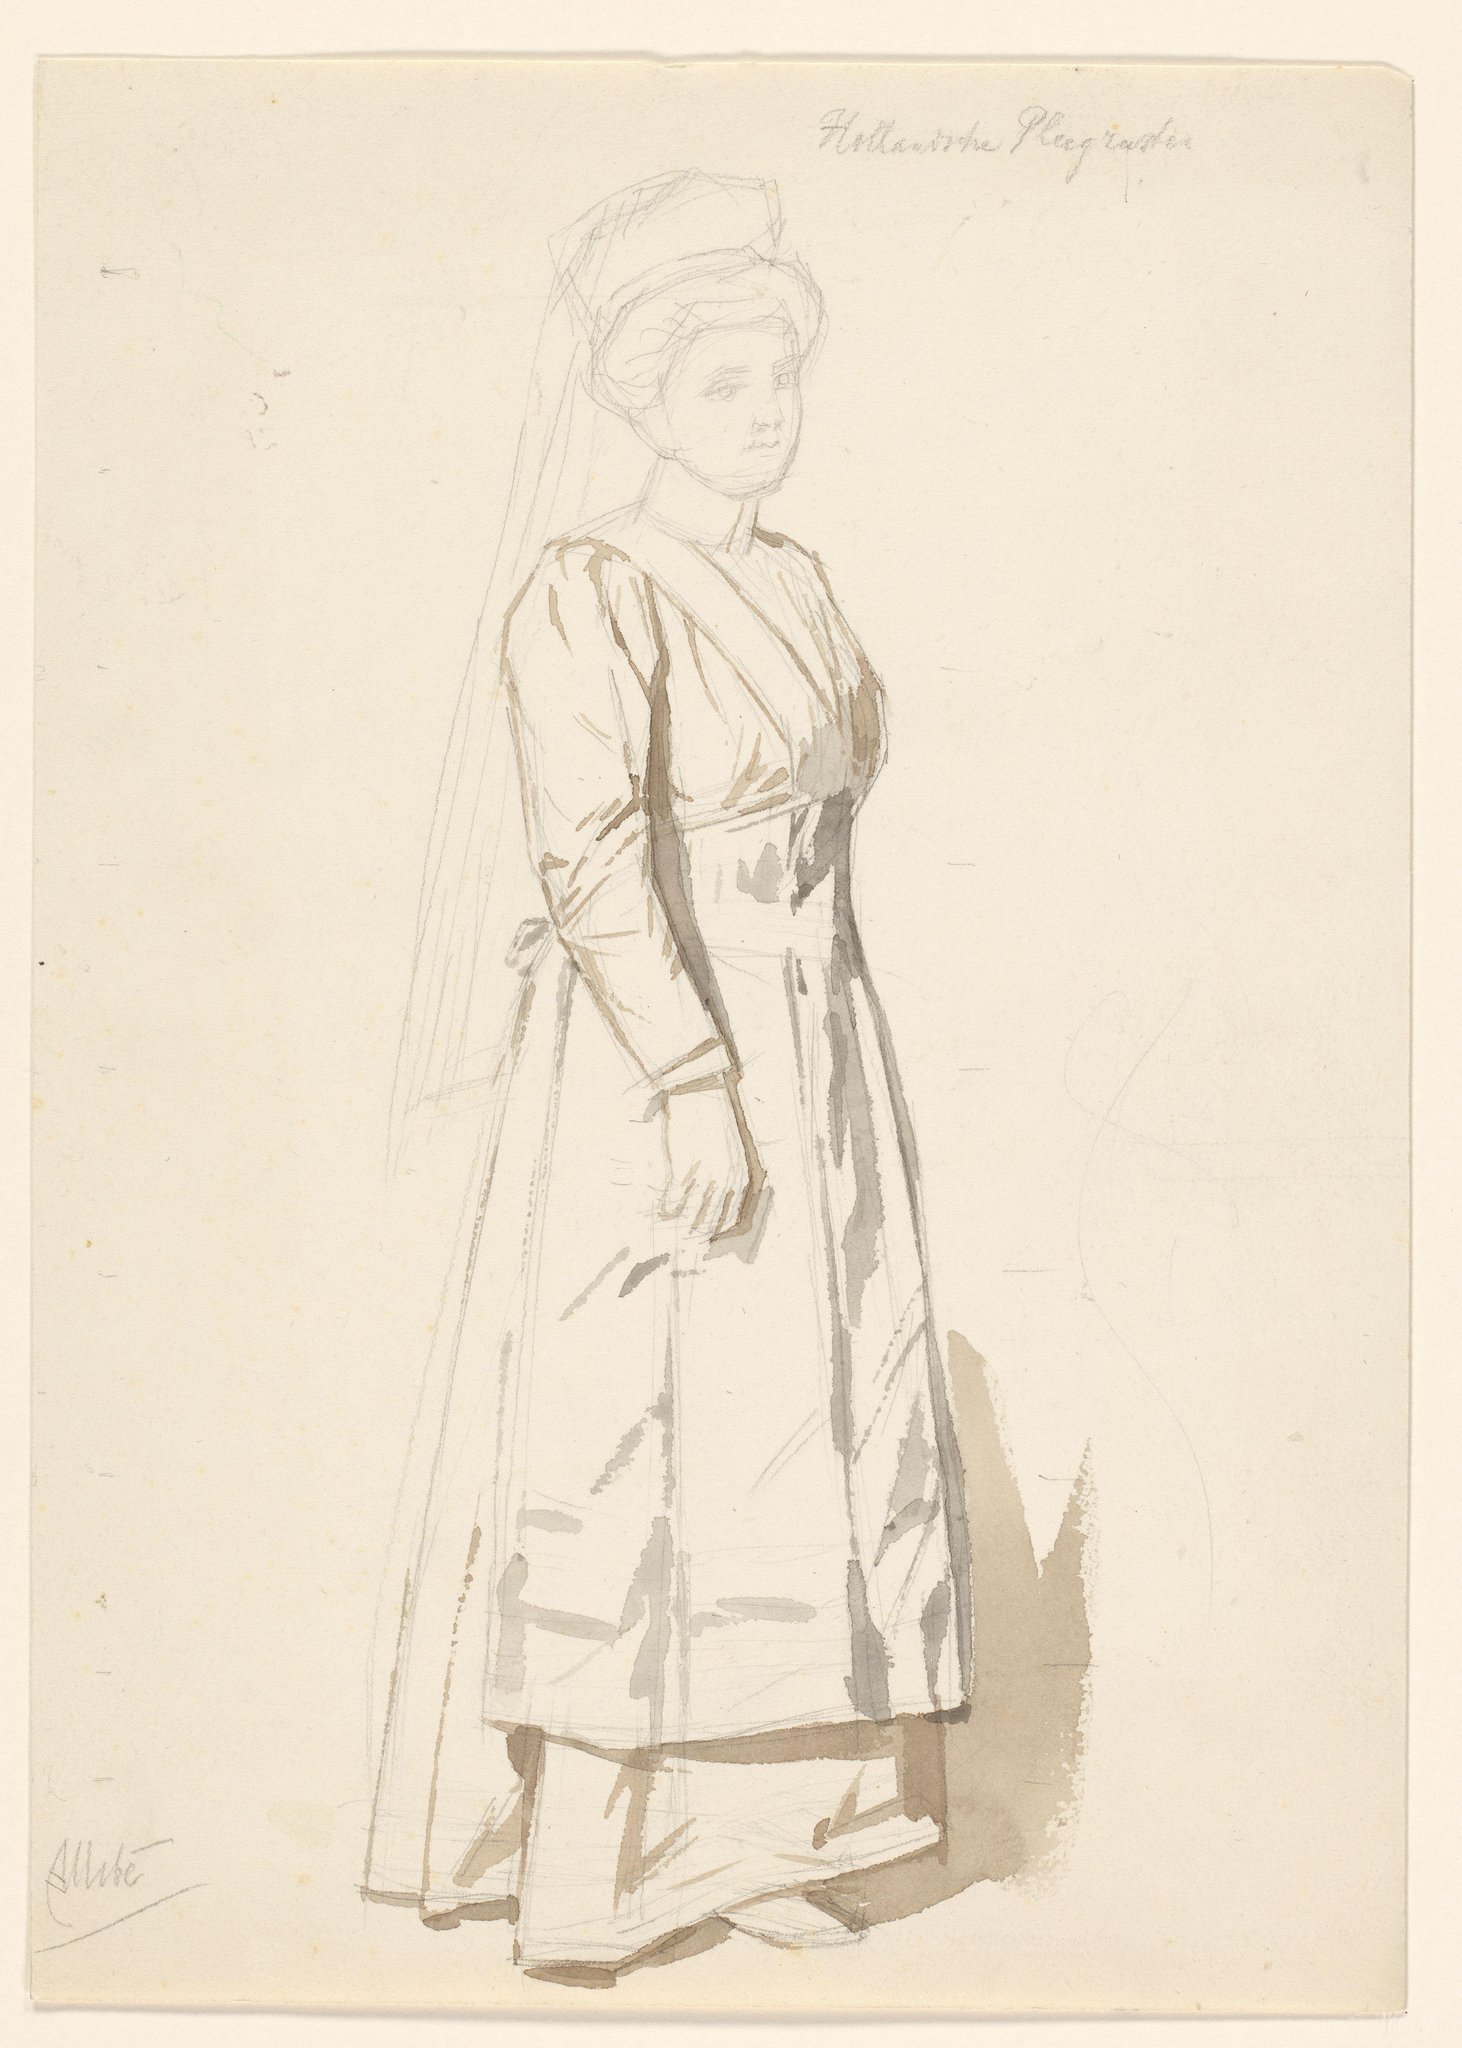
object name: drawing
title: Verpleegster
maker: august allebé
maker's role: draughtsman, print maker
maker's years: 1838-1927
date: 1848-1927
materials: paper, pencil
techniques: brush